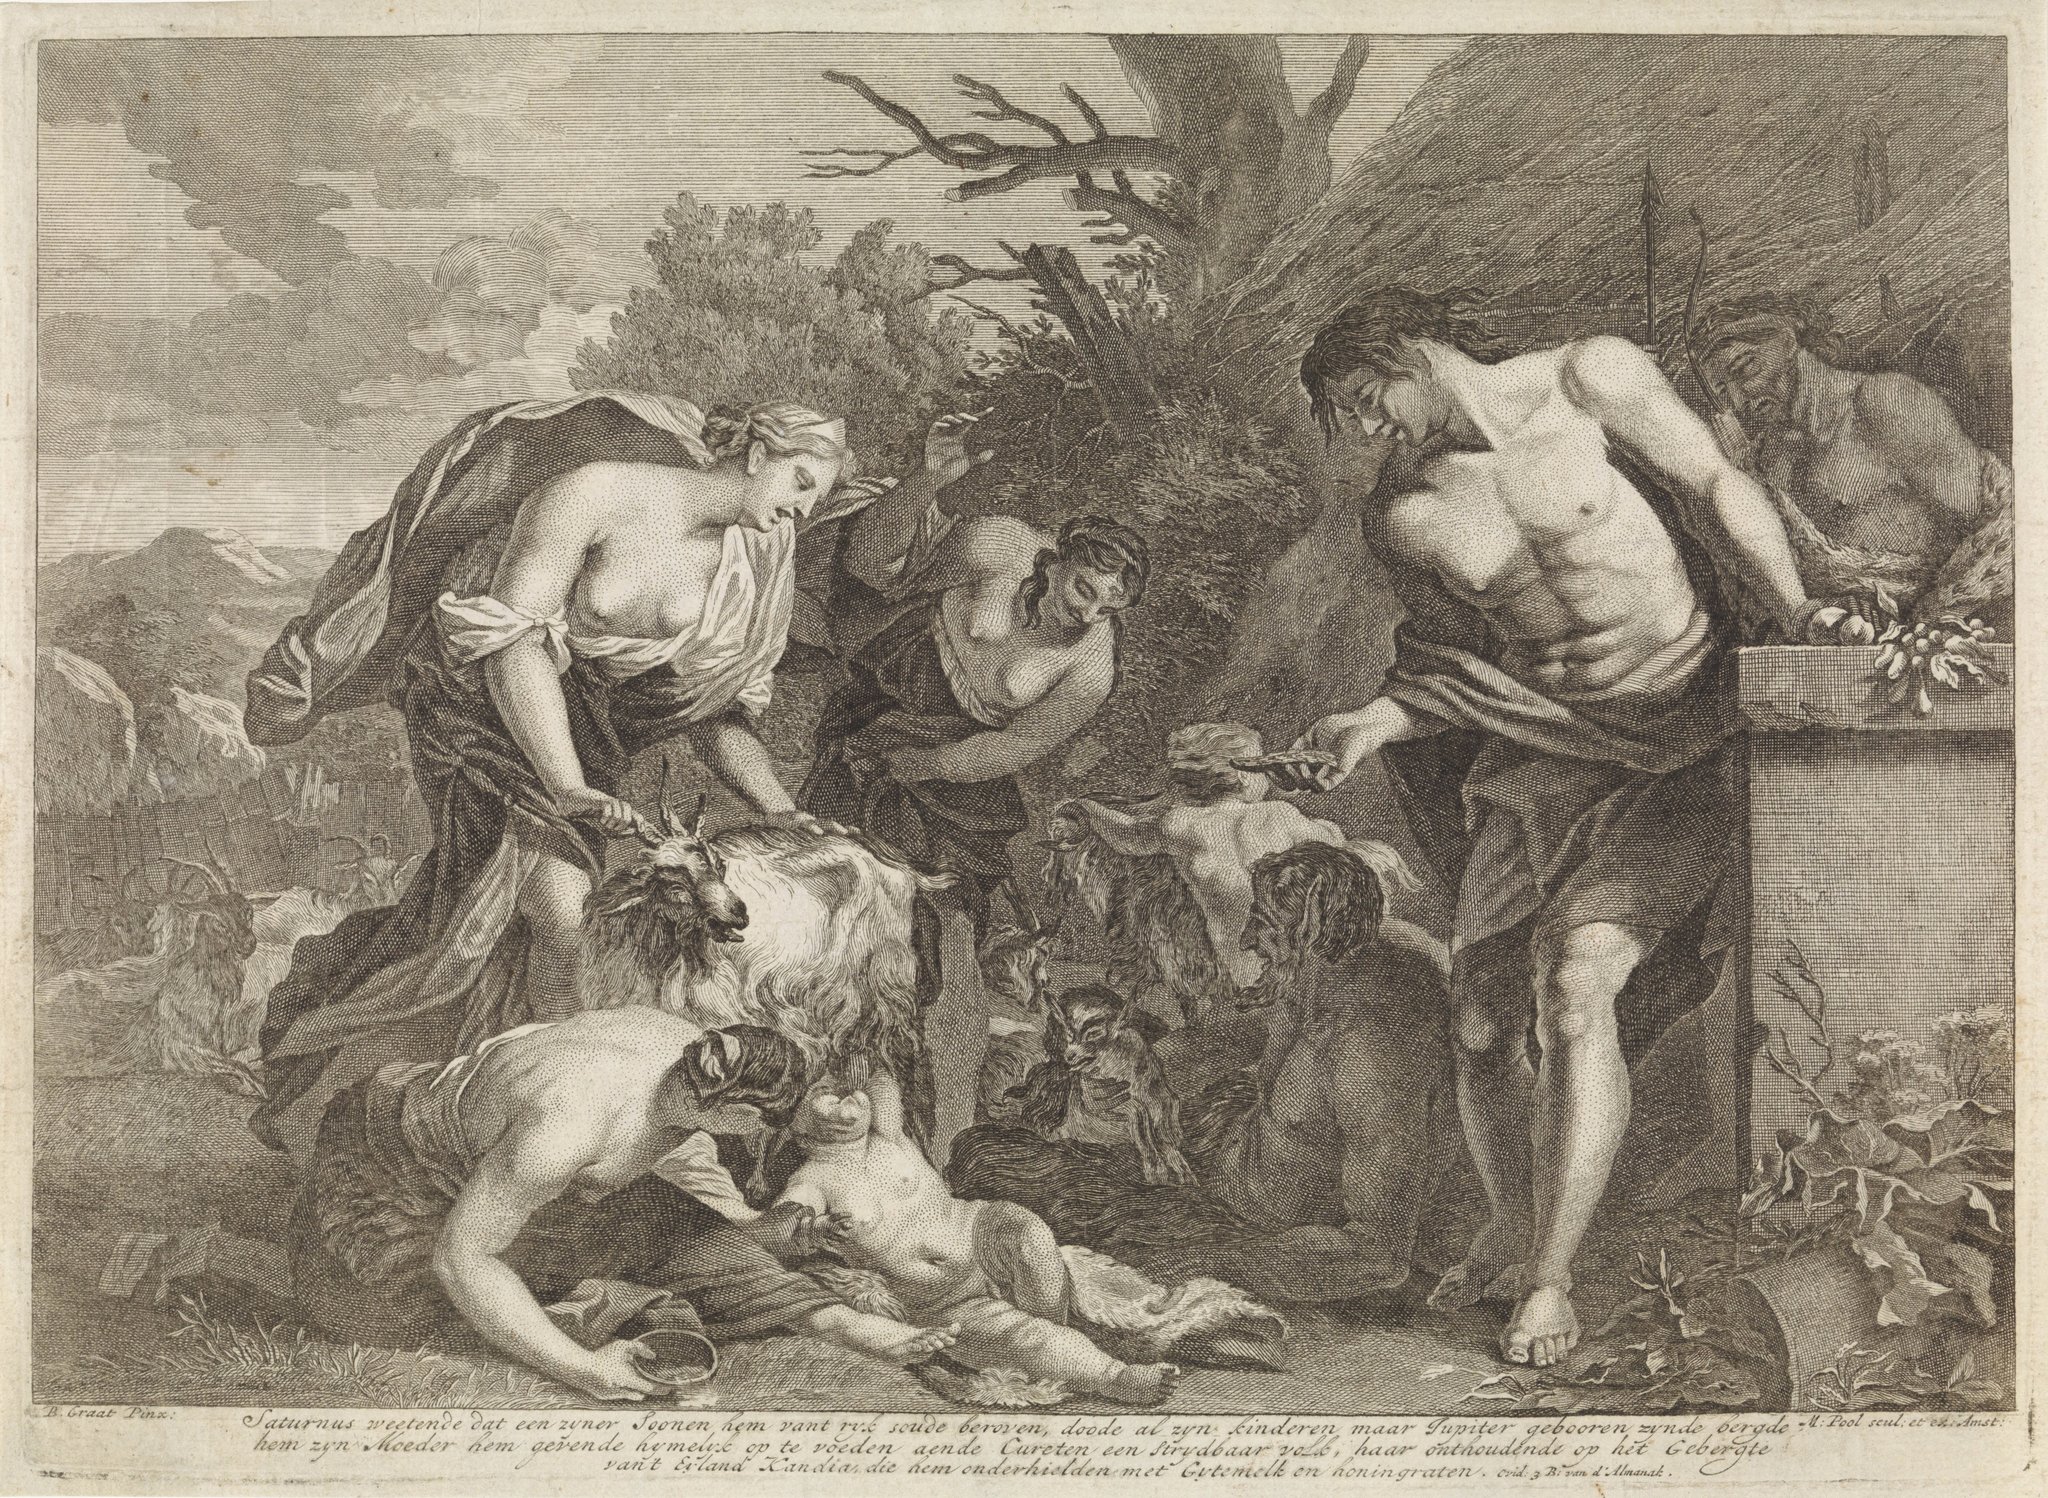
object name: print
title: Jupiter wordt gezoogd door de geit Amalthea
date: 1696-1727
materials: paper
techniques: engraving, etching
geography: amsterdam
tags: amalthea, the nymph, usually in the shape of a goat, suckles the new-born jupiter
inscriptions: collector's mark: Lugt 2228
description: Jupiter wordt door nimfen op de berg Ida grootgebracht. Ze voeden hem met de melk van de geit Amalthea. Een herder geeft hem honinggraten. In de marge een drieregelig onderschrift in het Nederlands.